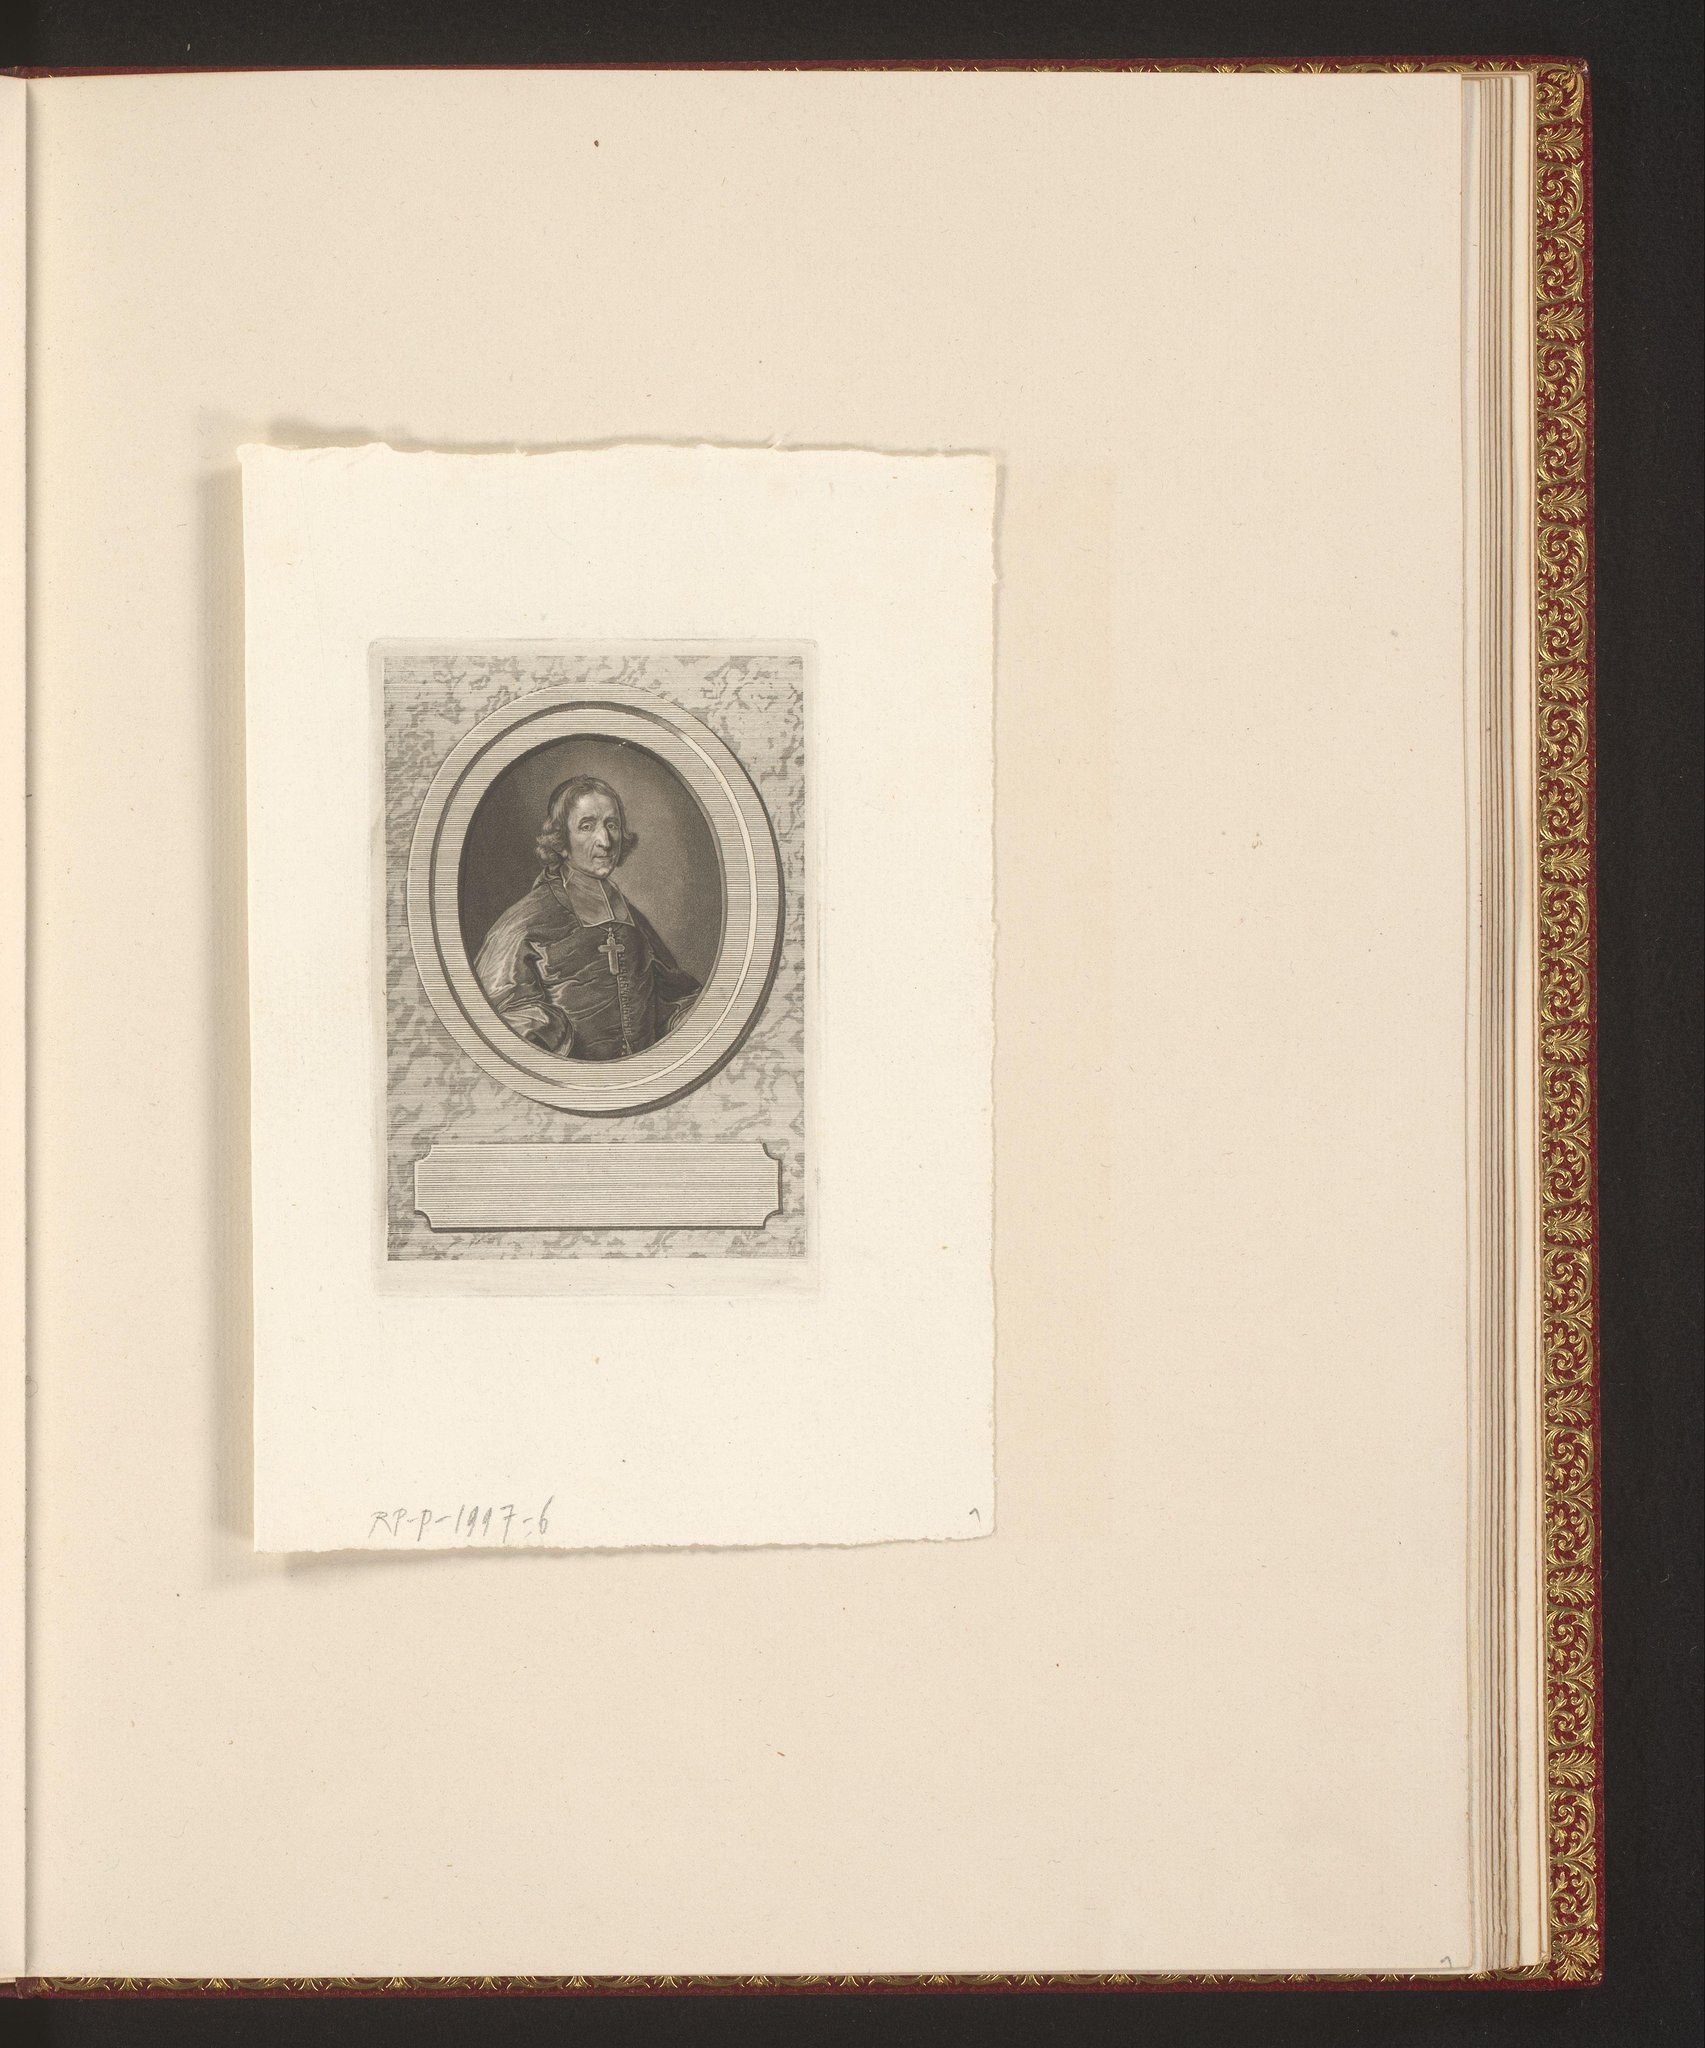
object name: album leaf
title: Portret van Francois Fénelon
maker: jean-baptiste de grateloup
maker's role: painter, print maker, sculptor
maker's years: 1735-1817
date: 1767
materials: paper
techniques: aquatint, etching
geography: france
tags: françois fénelon, scholar, philosopher, historical persons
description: Jean-Baptiste de Grateloup gebruikte een geheim proces bij het maken van zijn prenten, lijkend op aquatint. Zijn neef Jean-Pierre Sylvestre de Grateloup heeft ook op deze manier gewerkt.